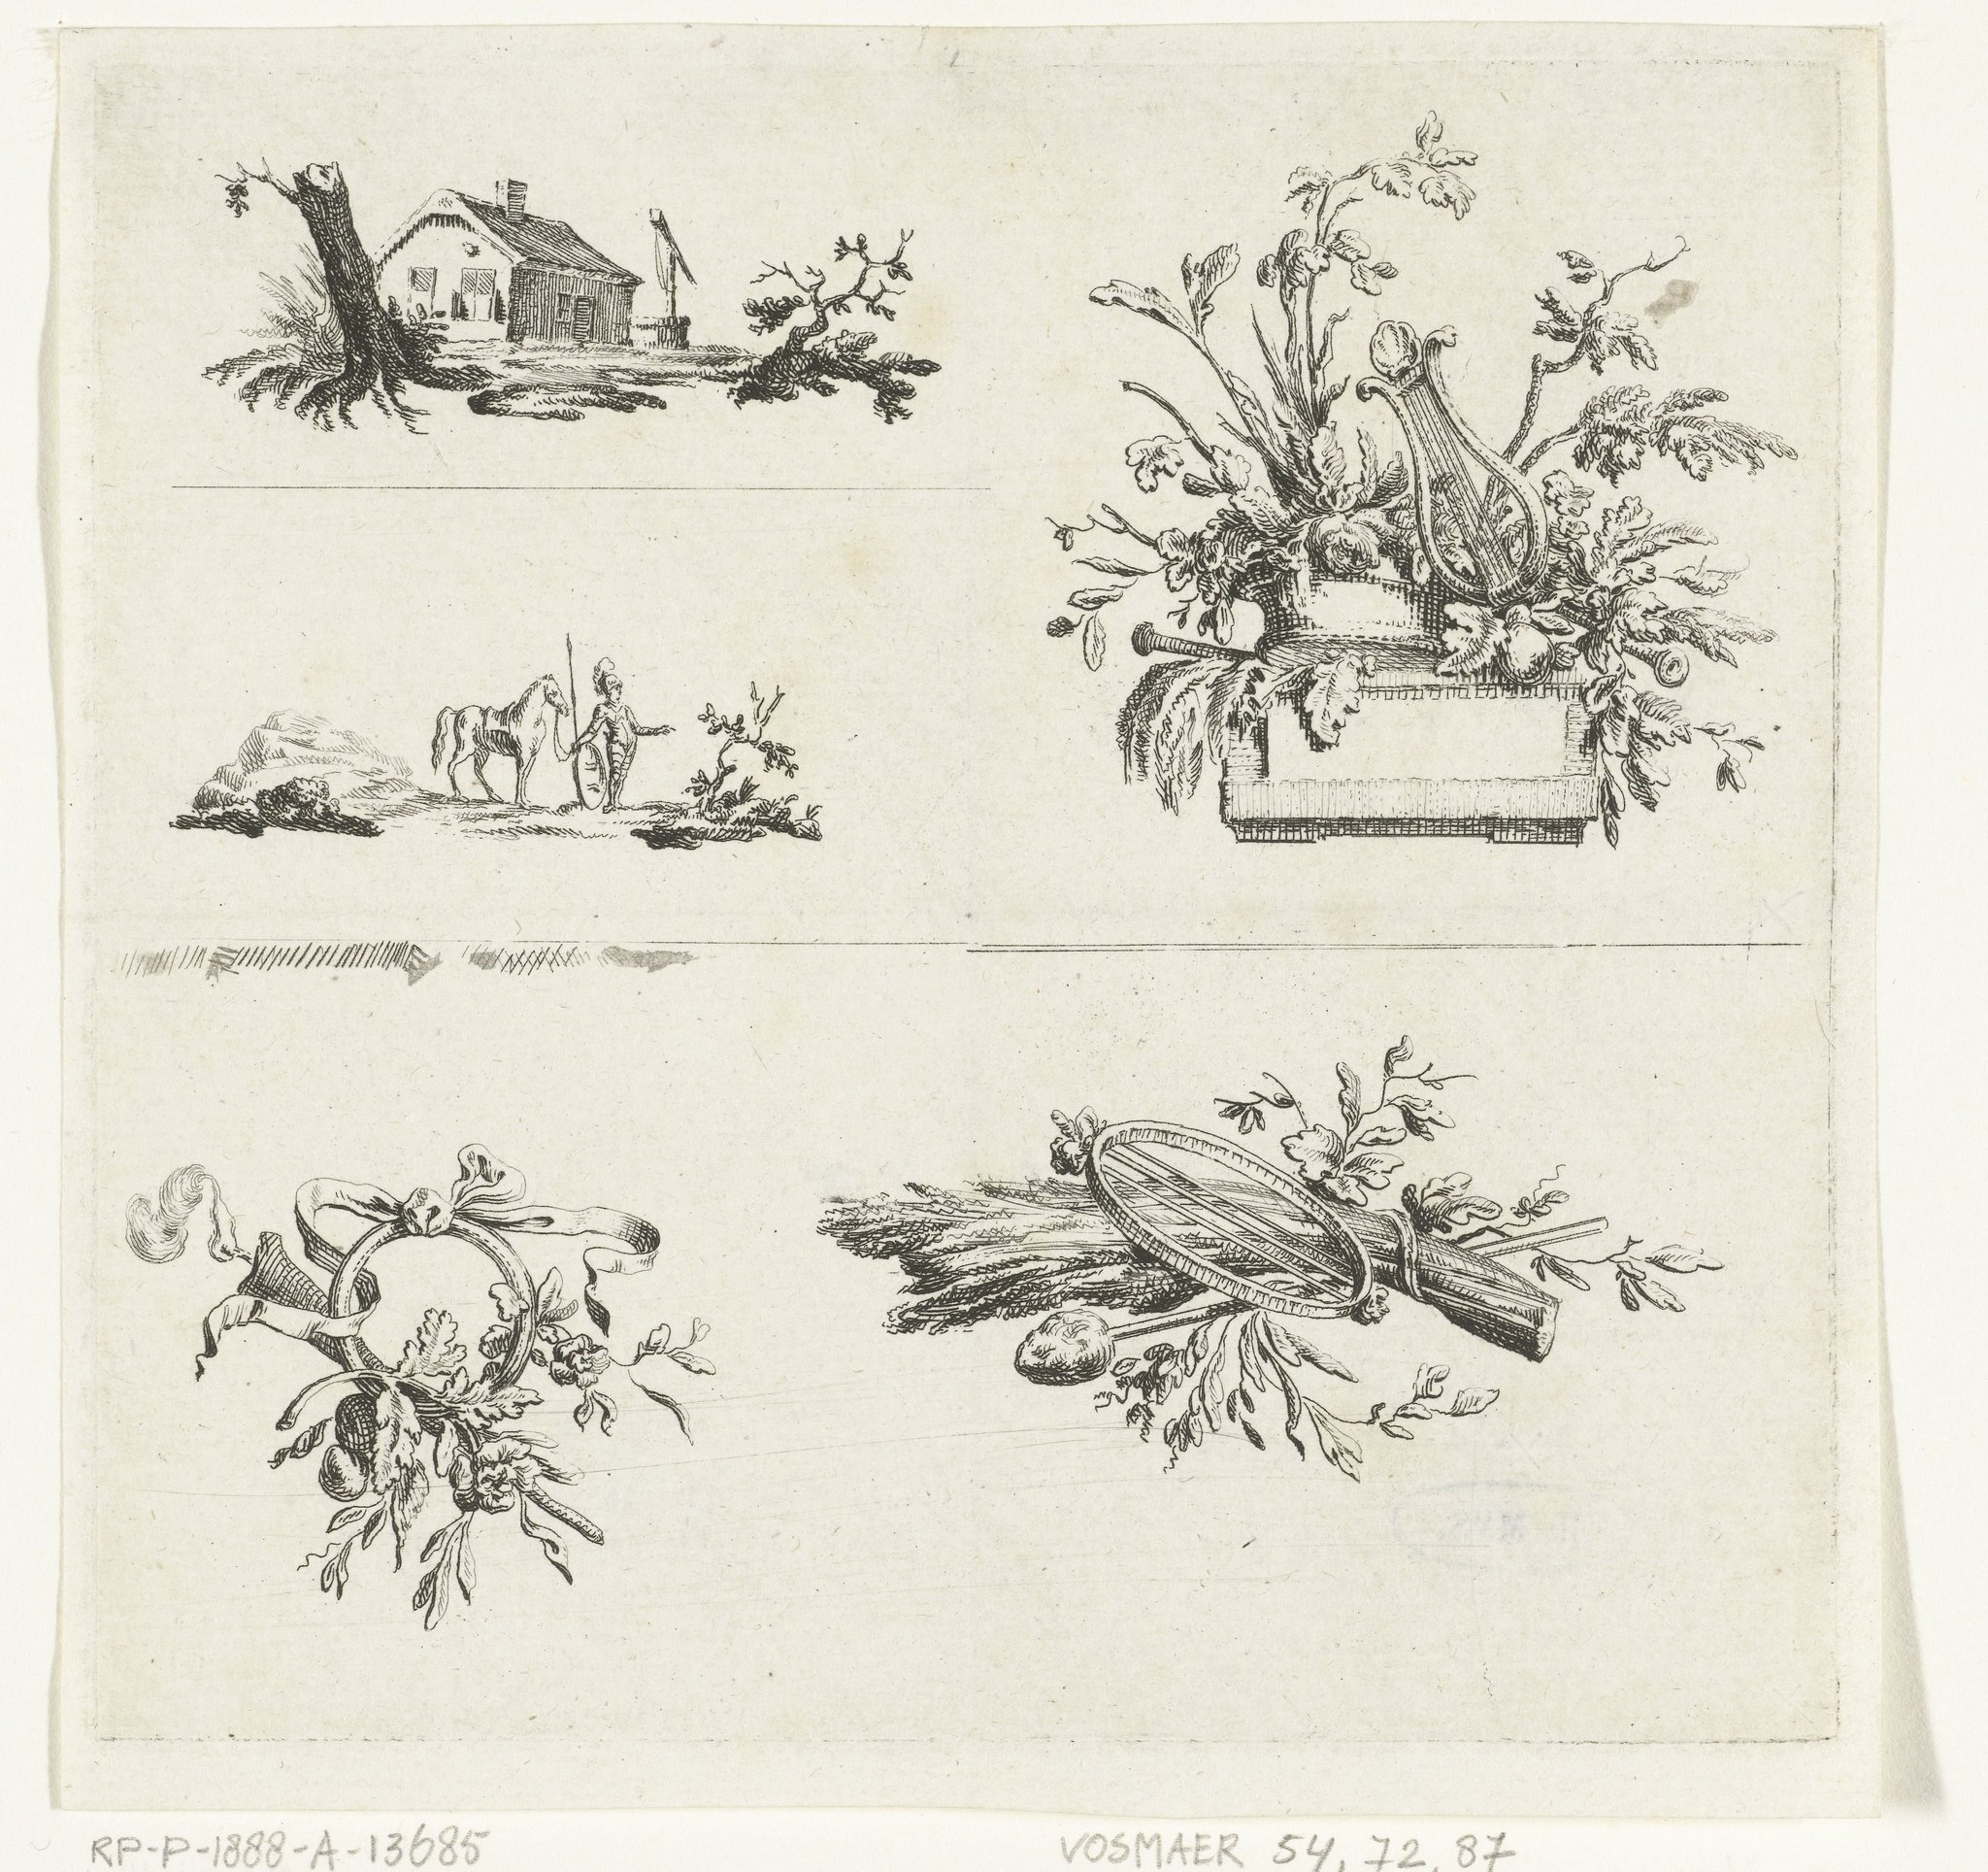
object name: print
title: Blad met vijf vignetten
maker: willem bilderdijk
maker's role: draughtsman, print maker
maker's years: 1756-1831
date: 1766-1785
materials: paper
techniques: etching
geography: netherlands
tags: torch, lyre, cithara, psaltery, private soldier, sheaf, farm or solitary house in landscape, vignette, flowers ~ ornament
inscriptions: collector's mark: Lugt 2228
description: Etsplaat later in losse plaatjes gesneden en twee vignetten gebruikt voor: Bilderdijk, W., Bloemtjens, Pieter Johannes Uylenbroek Amsterdam 1785. De bloemenmand met lier werd gebruikt voor de titelpagina, in dat geval staat op het voetstuk het opschrift Delectent. Het vignet met de brandende fakkel en (hier) onbeschreven band werd gebruikt in: Bilderdijk, Willem, Elius romance, Pierre Frederik Gosse, Den Haag (mogelijk uitgever, mogelijk plaats) 1786 met het opschrift Verdien en win (Vosmaer 1870, p. 91-94).